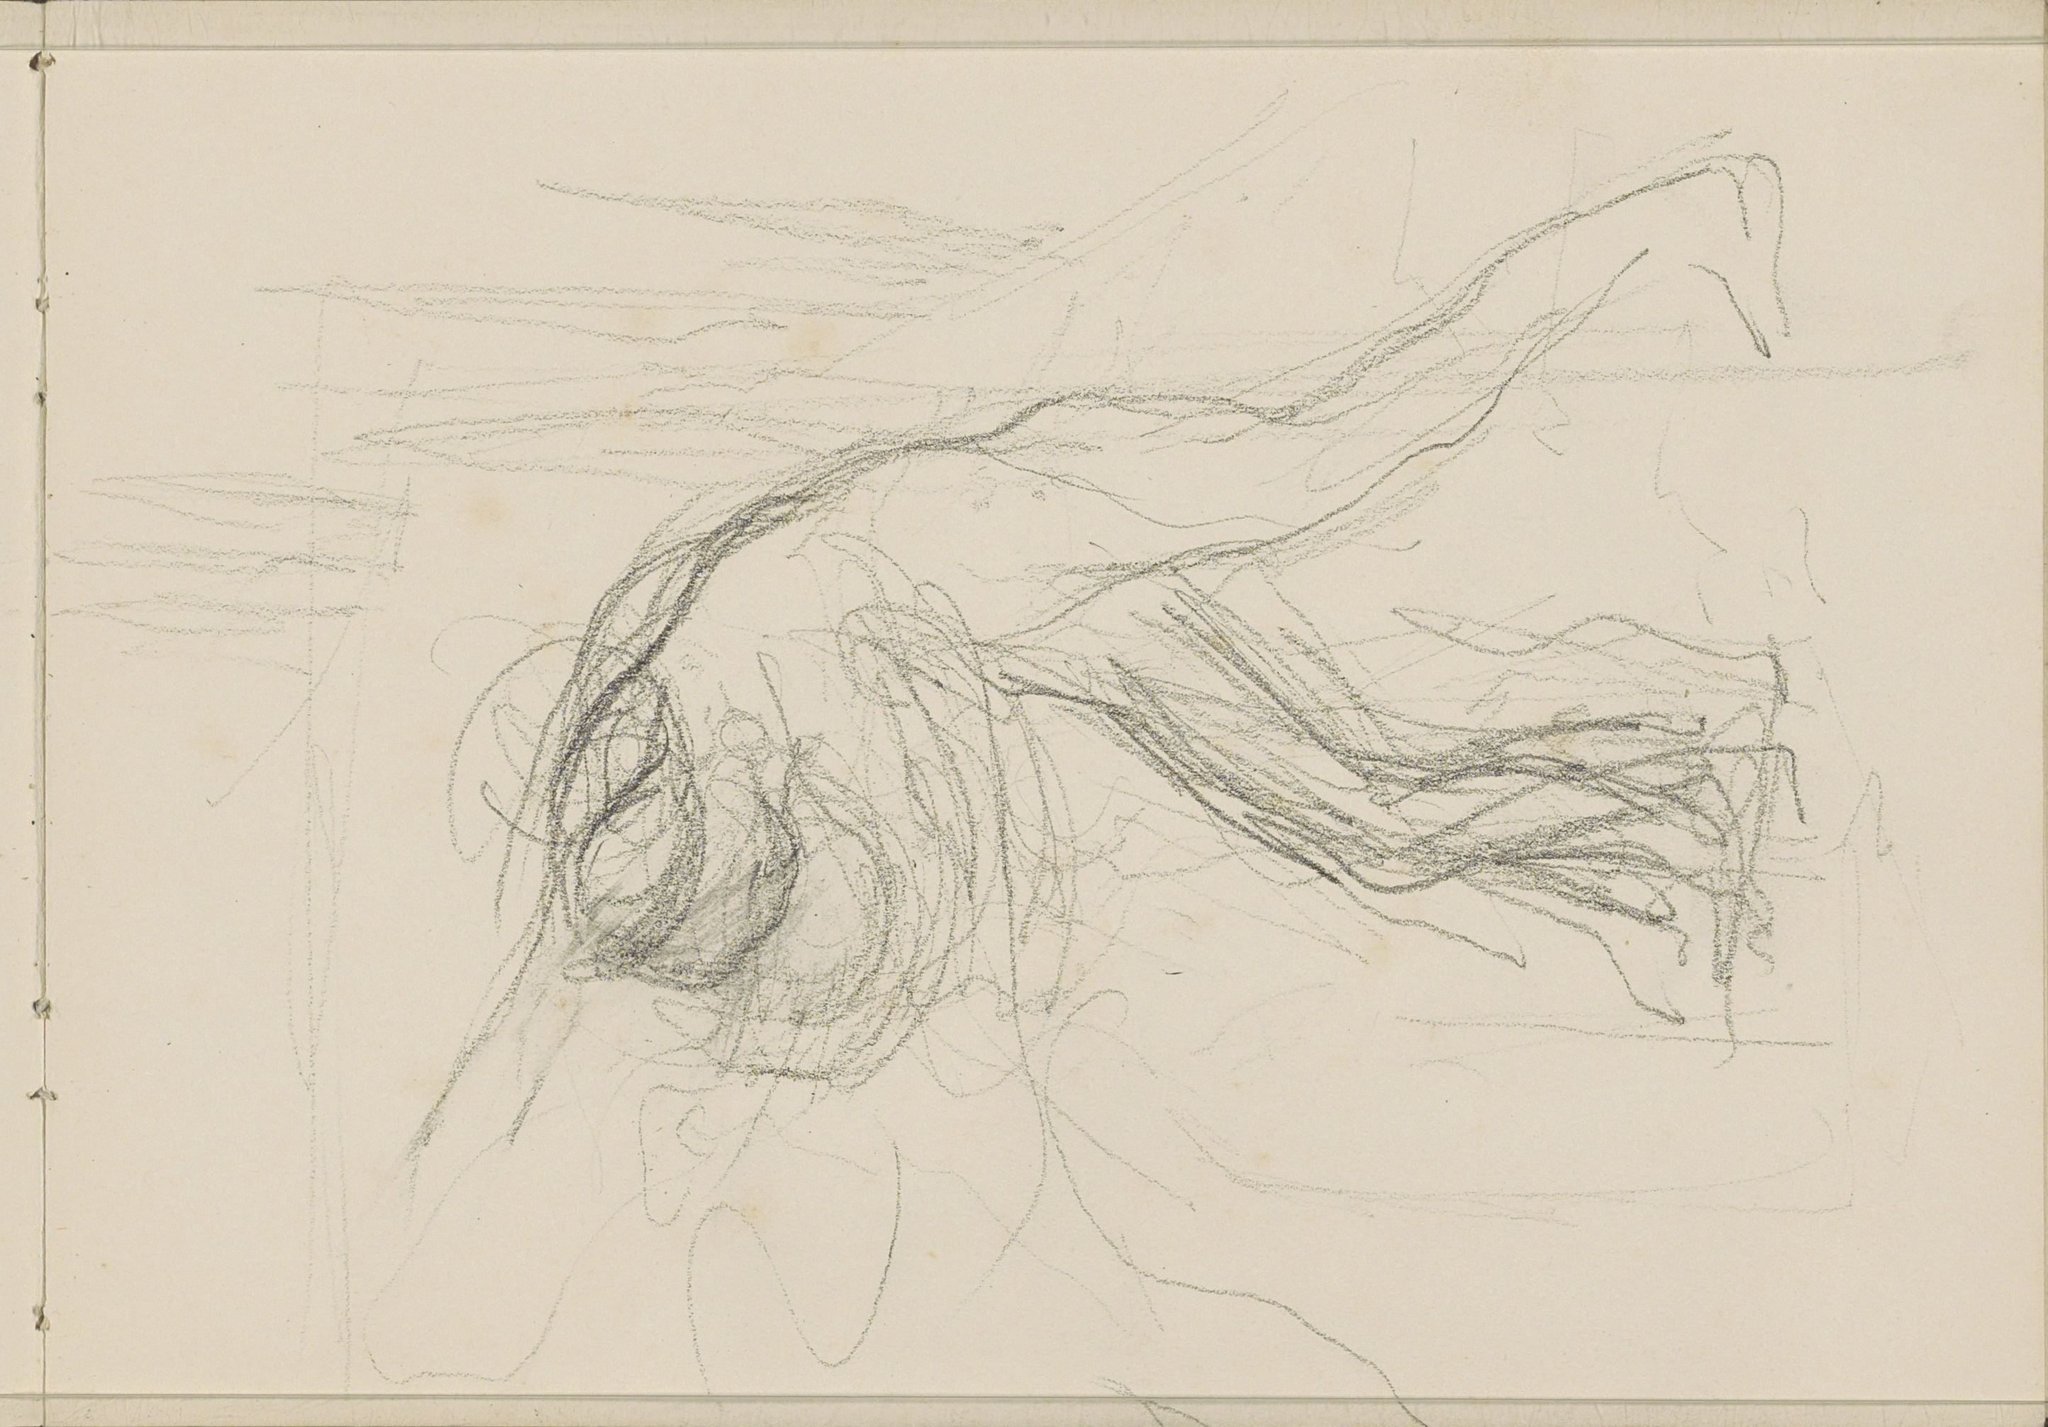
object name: sketchbook leaf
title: Figuur met uitgestrekte armen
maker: a.a.l. de grammont-hubrecht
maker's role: draughtsman, painter, print maker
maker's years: 1855-1913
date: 1865-1913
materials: paper, pencil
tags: anatomy (non-medical), arm stretched forward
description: Blad 3 recto uit een schetsboek met 68 bladen.